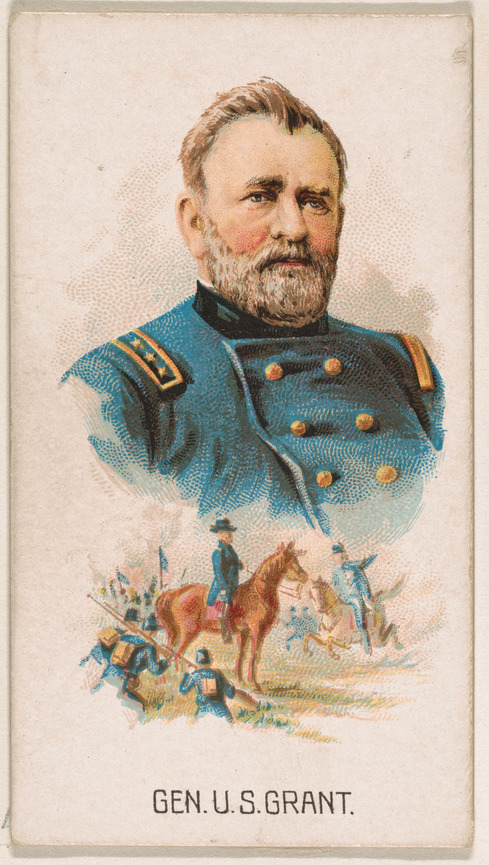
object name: print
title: General Ulysses S. Grant, from Leaders series (N222) issued by Kinney Bros.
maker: kinney brothers tobacco company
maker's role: publisher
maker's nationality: american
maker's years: 1869-2011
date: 1888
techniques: color lithograph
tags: men,generals